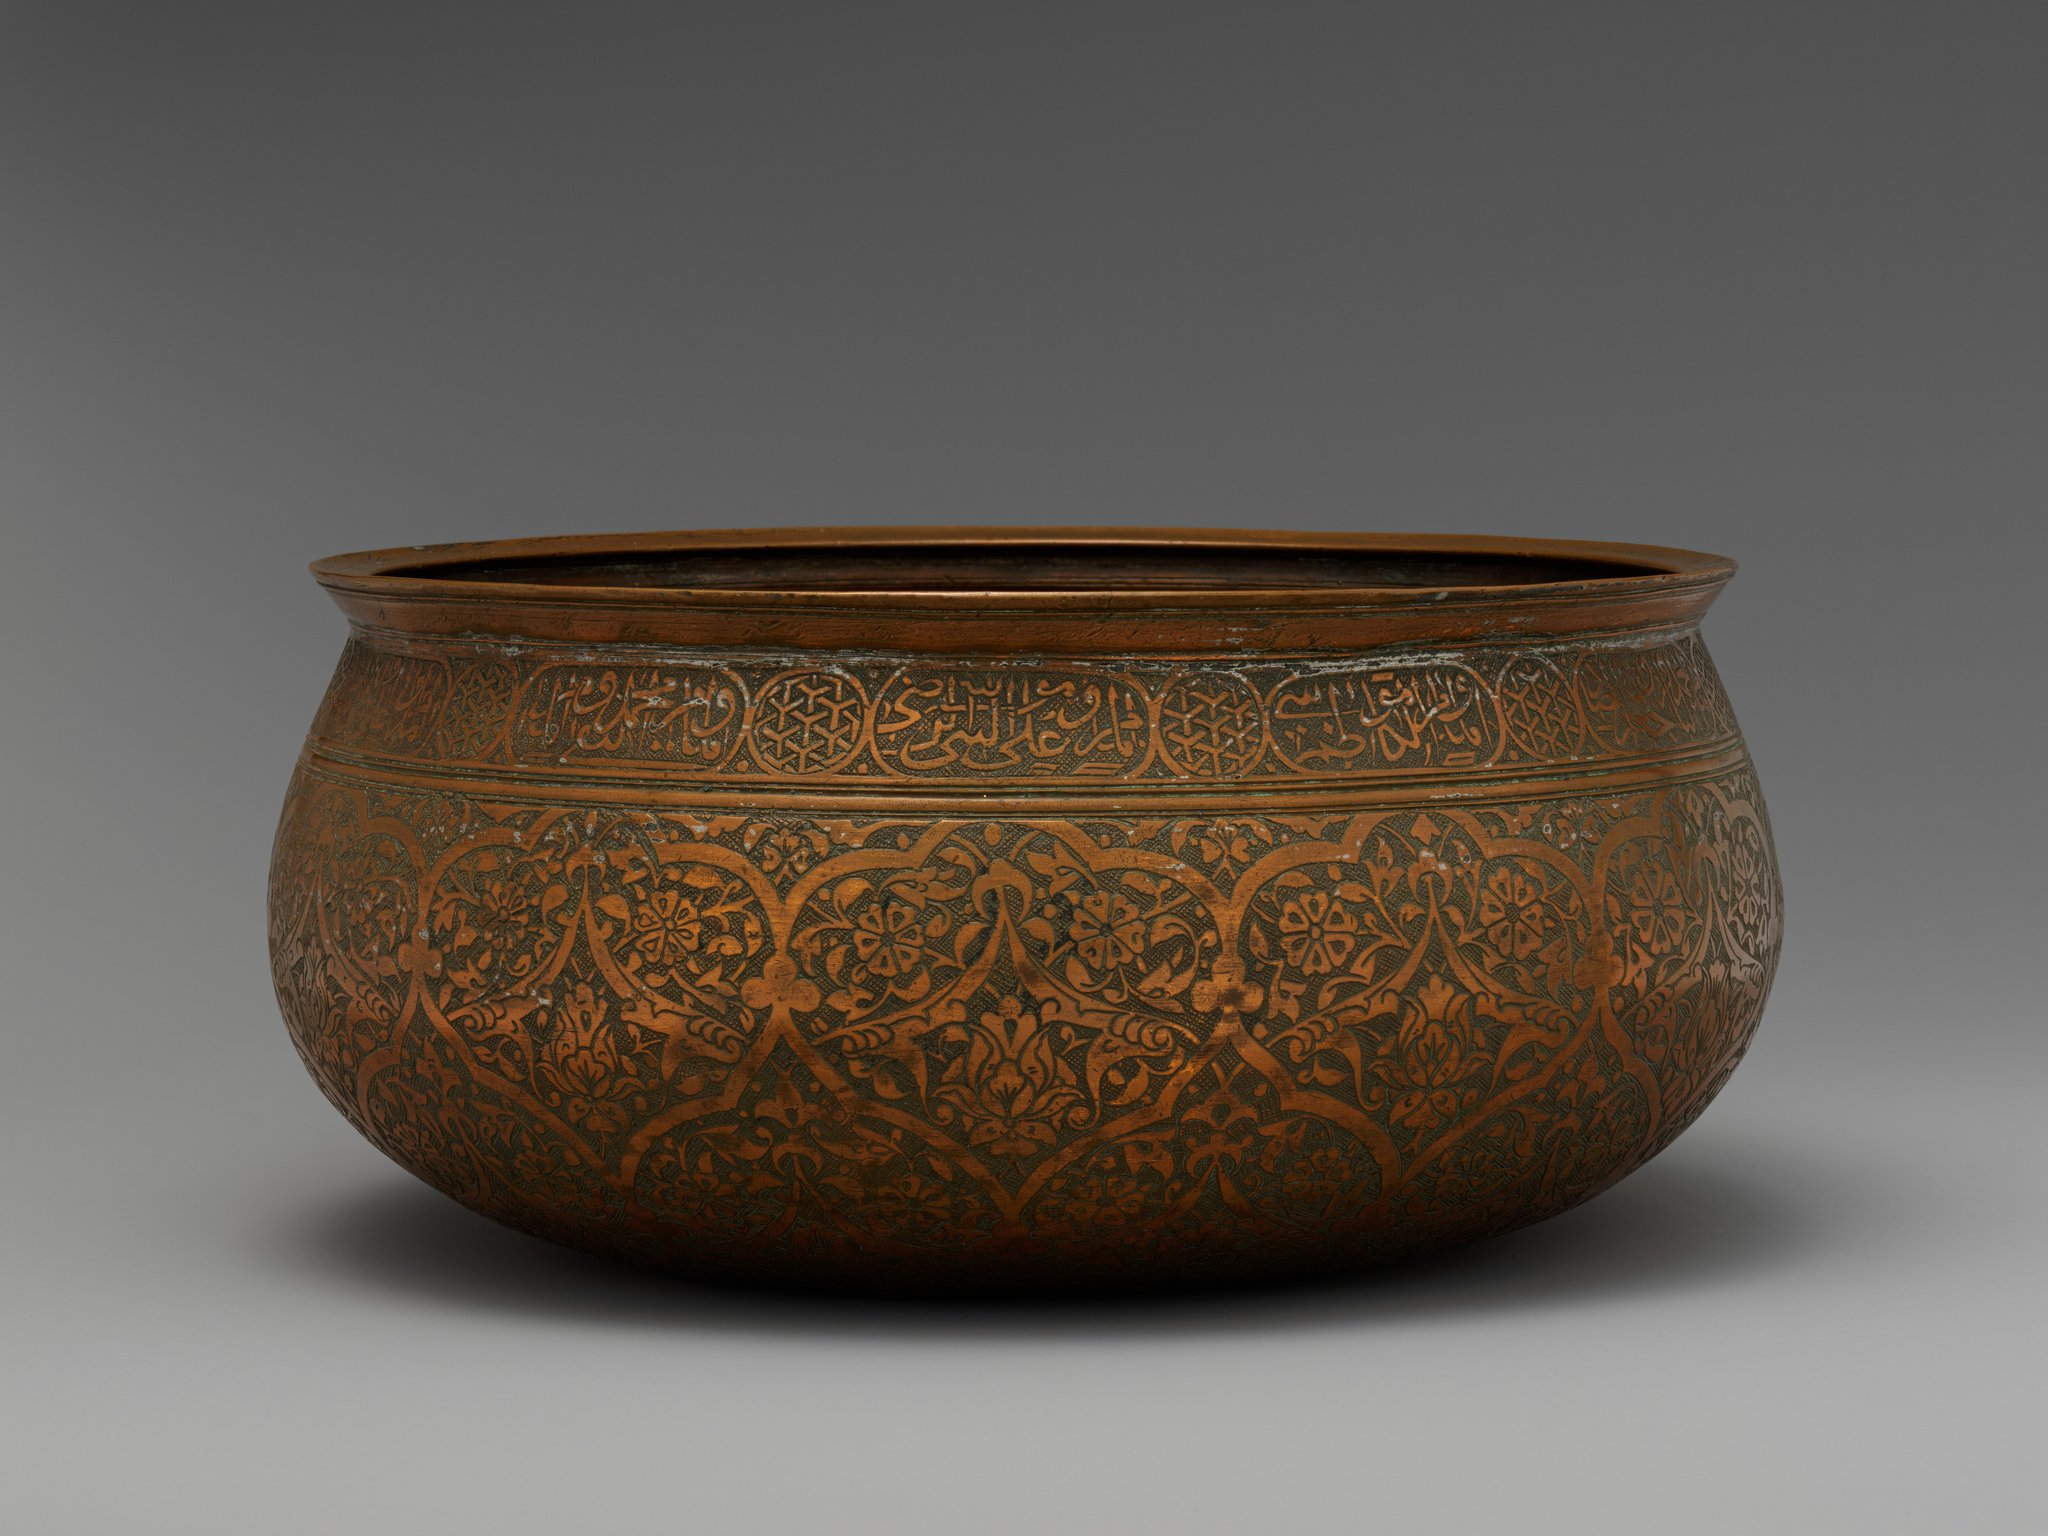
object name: bowl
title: Bowl with Inscription Cartouches and Repeating Floral Ornament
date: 1501-1700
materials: copper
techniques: chasing, relief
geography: iran